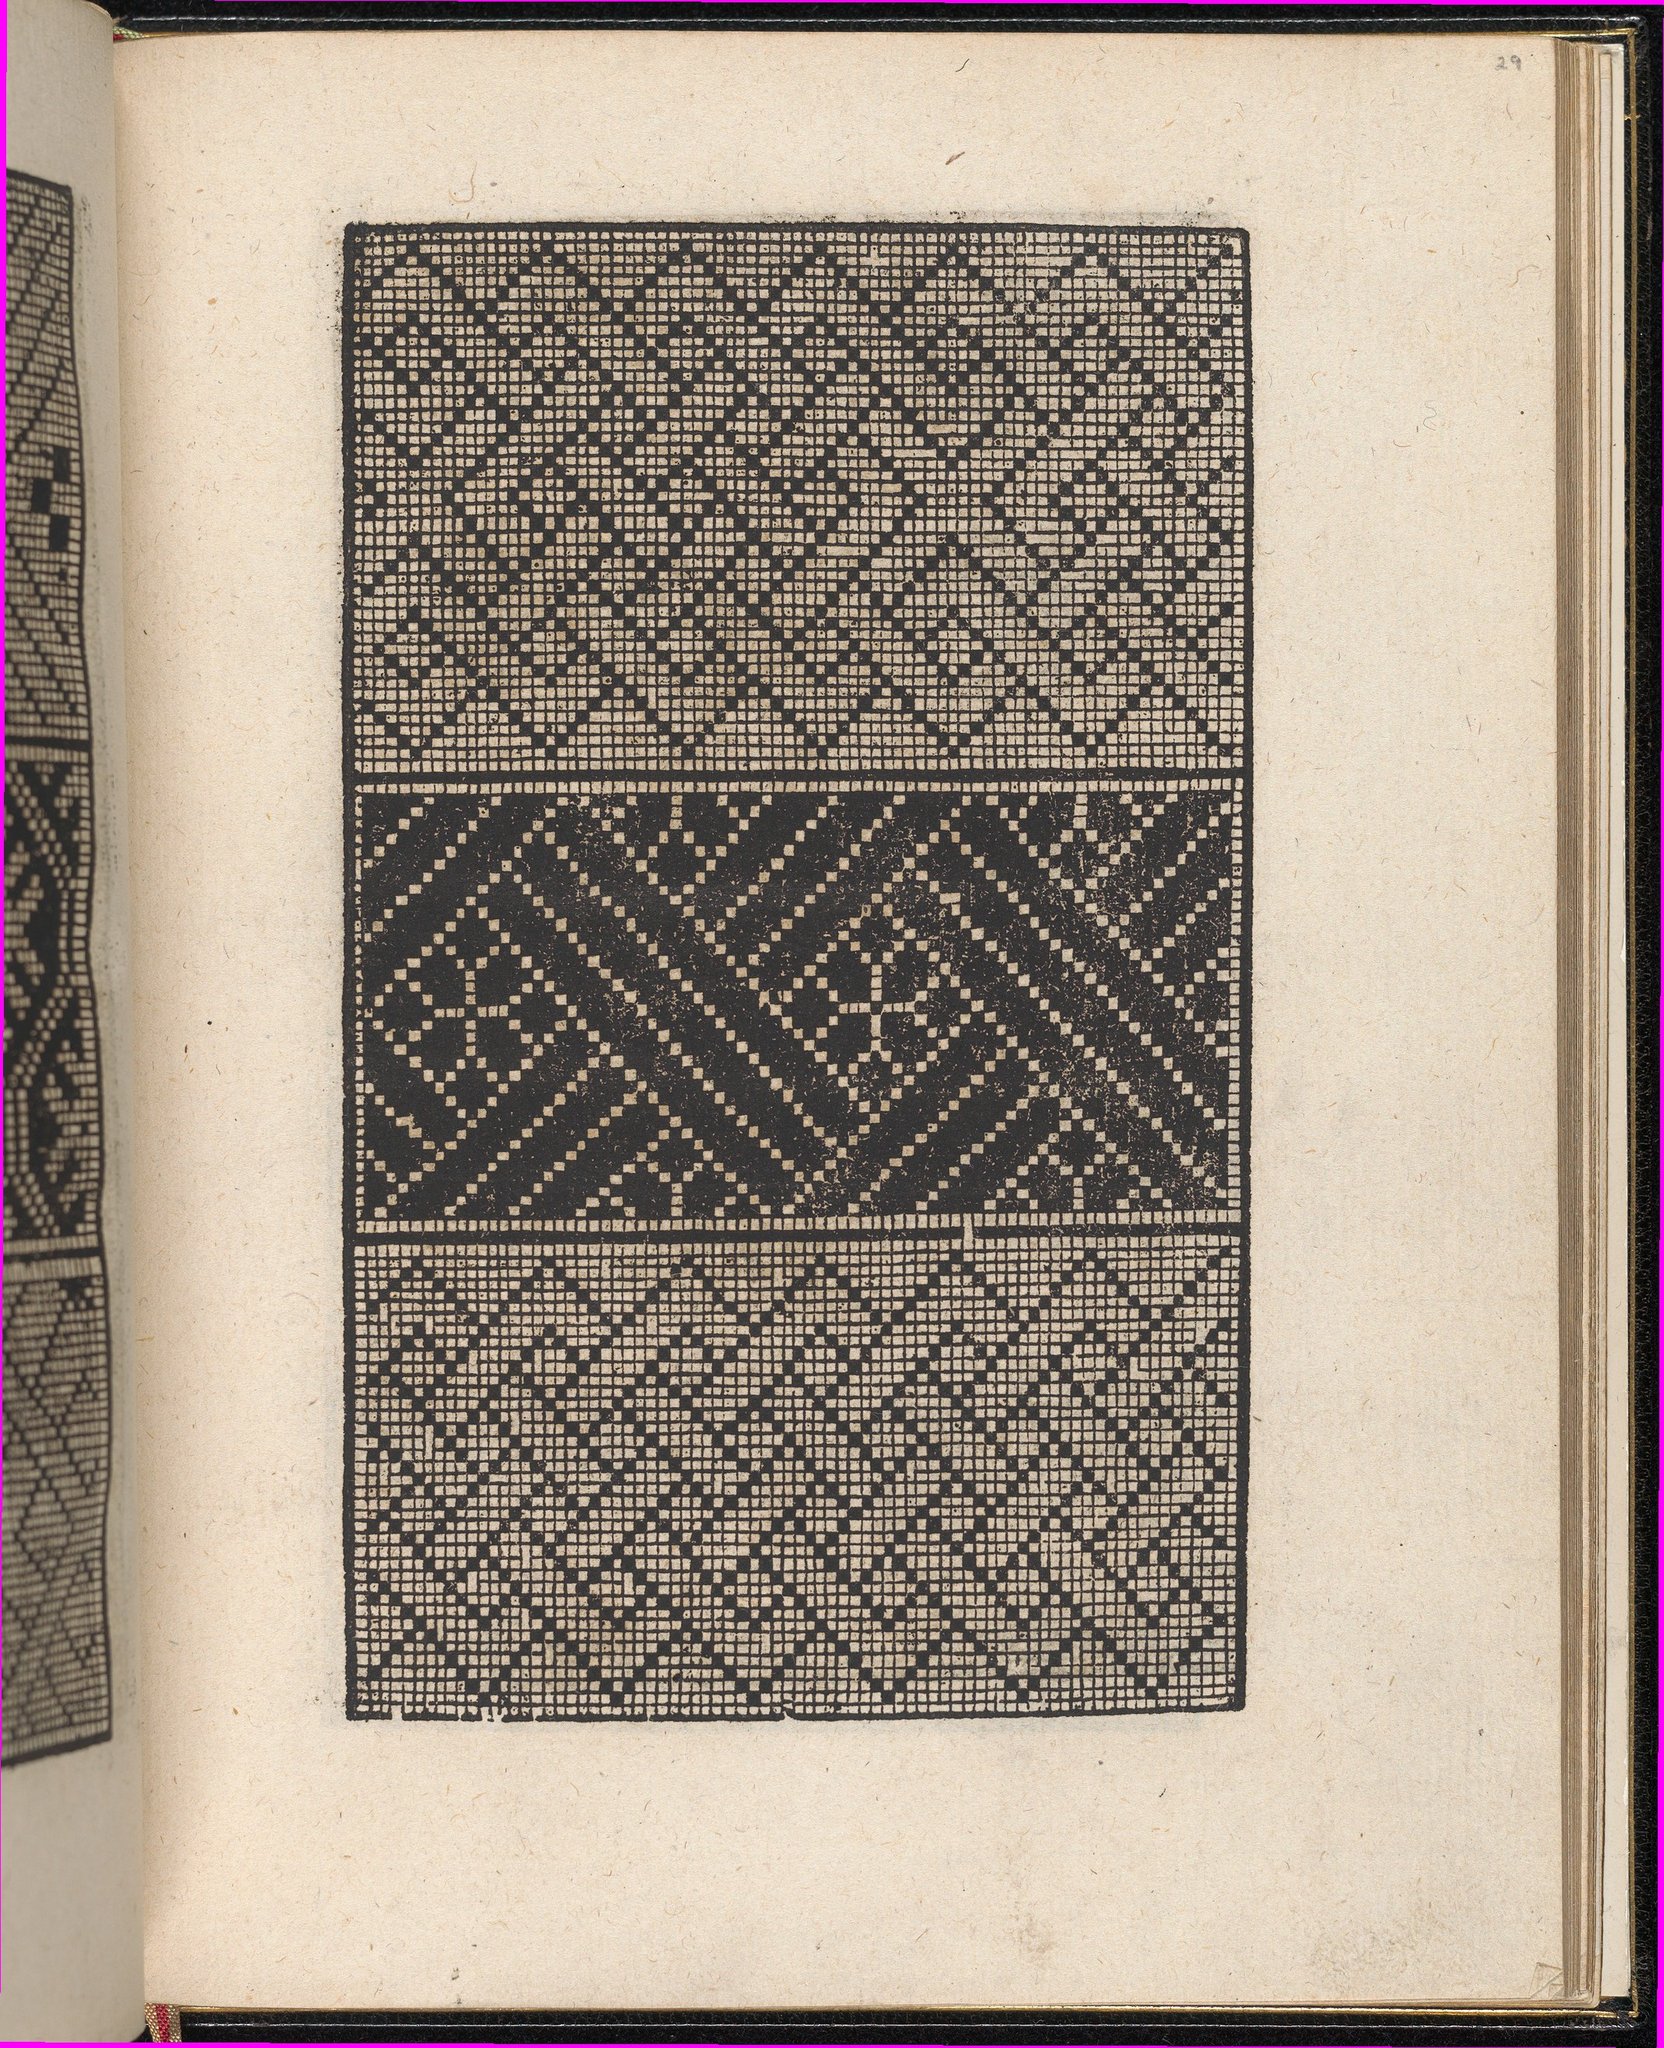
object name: book print ornament architecture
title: Page from Ein new kunstlich Modelbuch...(Page 29r)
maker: peter quentel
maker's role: publisher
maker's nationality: german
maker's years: 1500-1550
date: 1544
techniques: woodcut